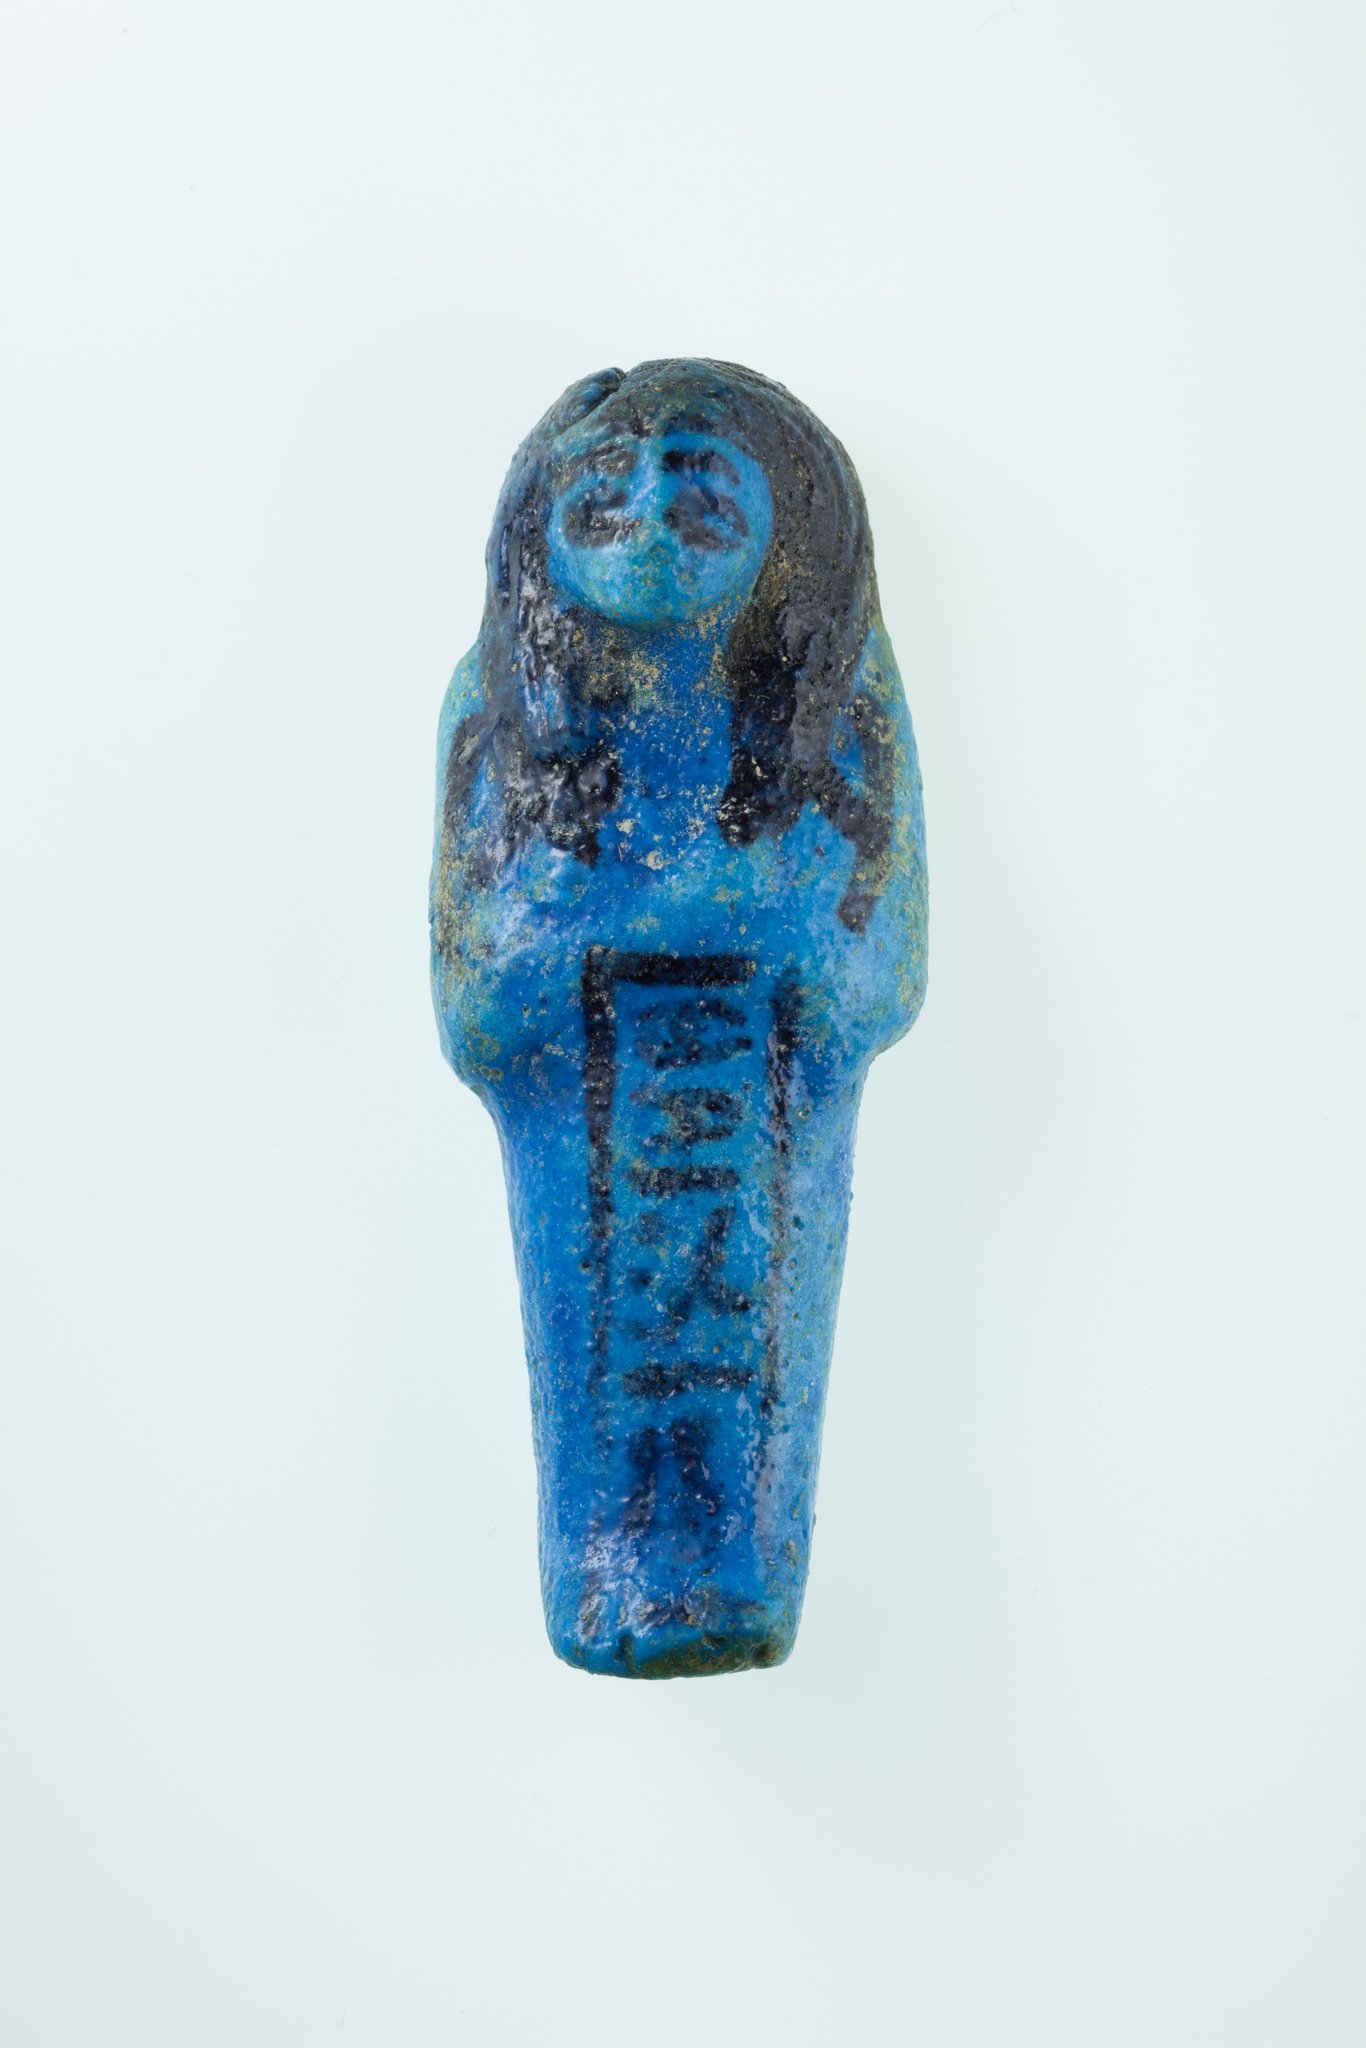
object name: shabti, worker, nauny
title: Worker Shabti of Nauny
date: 1050 BCE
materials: faience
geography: egypt